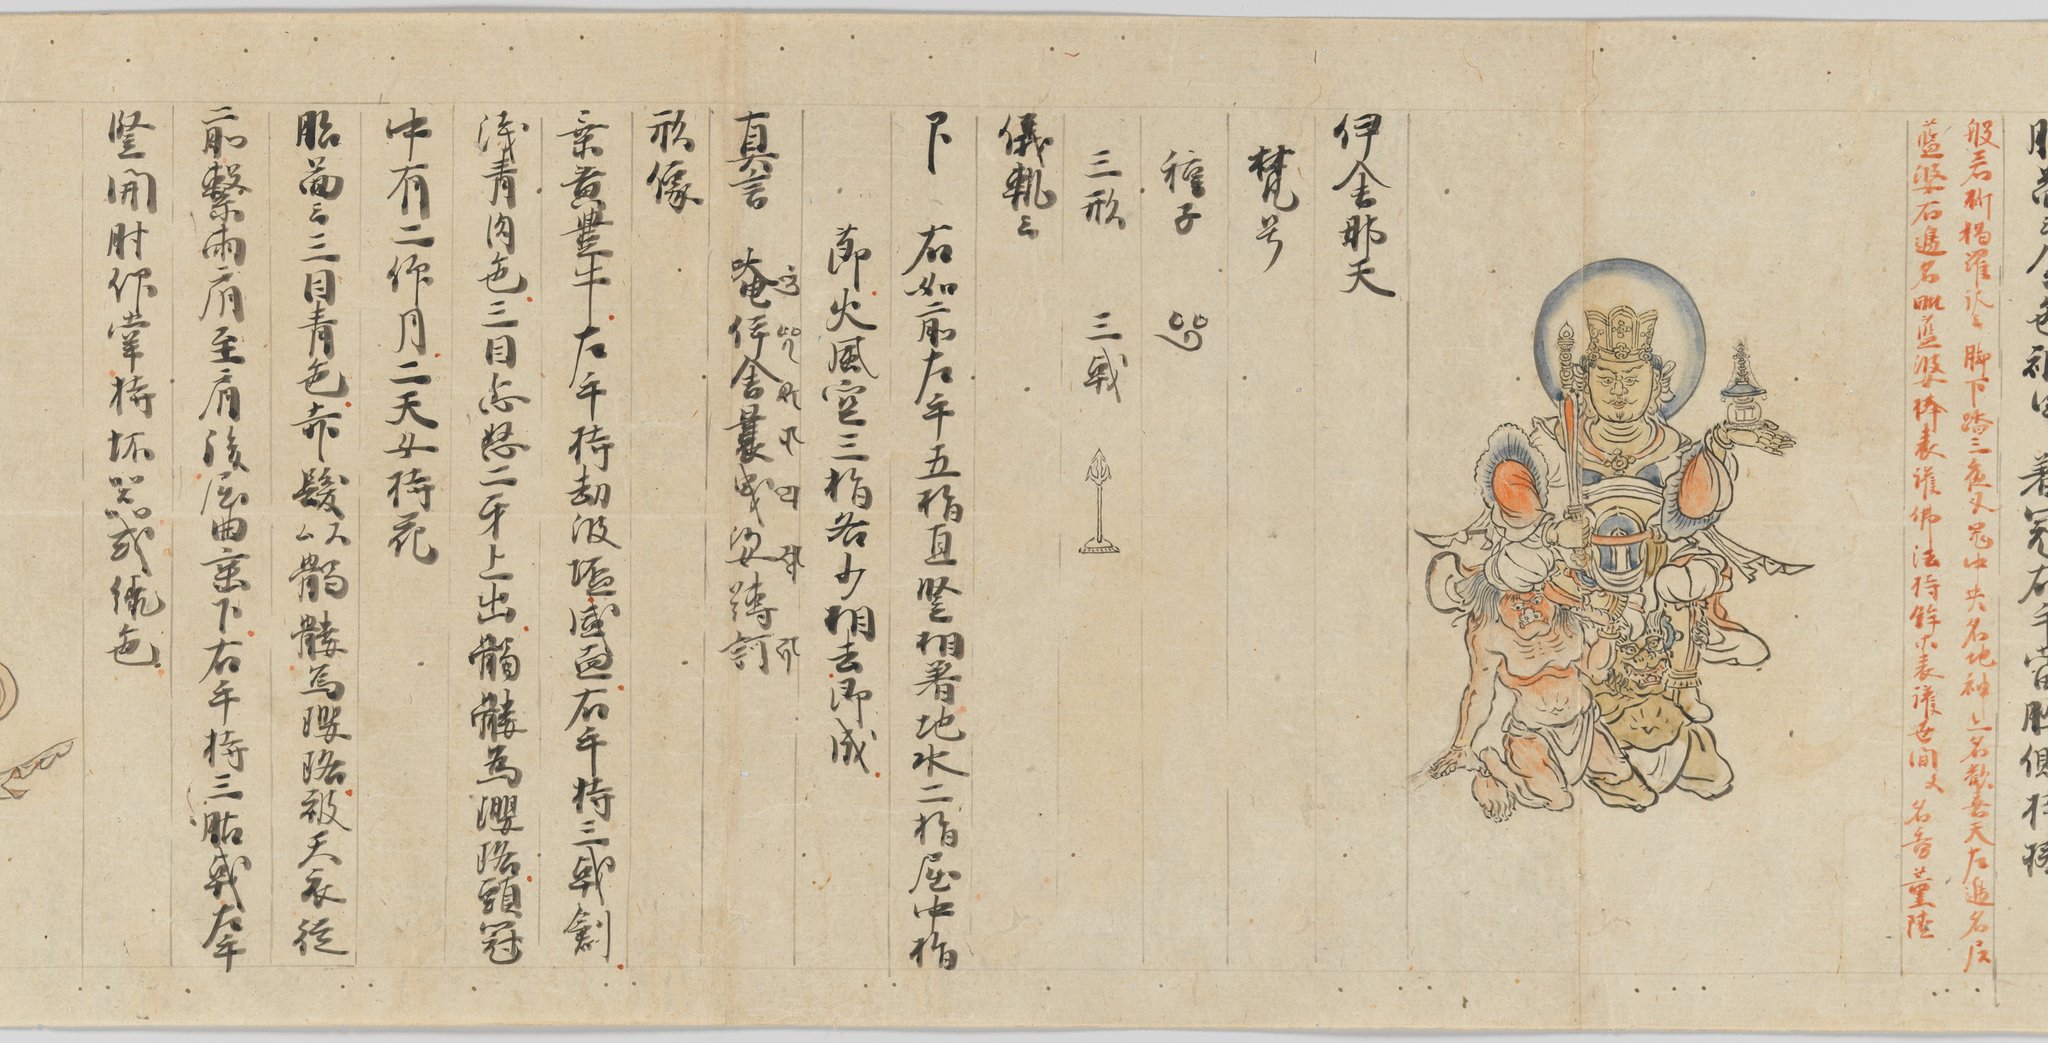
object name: handscroll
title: Scroll 9 of Collected Iconography (Zuzōshō): Ten (Devas)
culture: japanese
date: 1201-1300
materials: ink, paper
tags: buddhism,deities